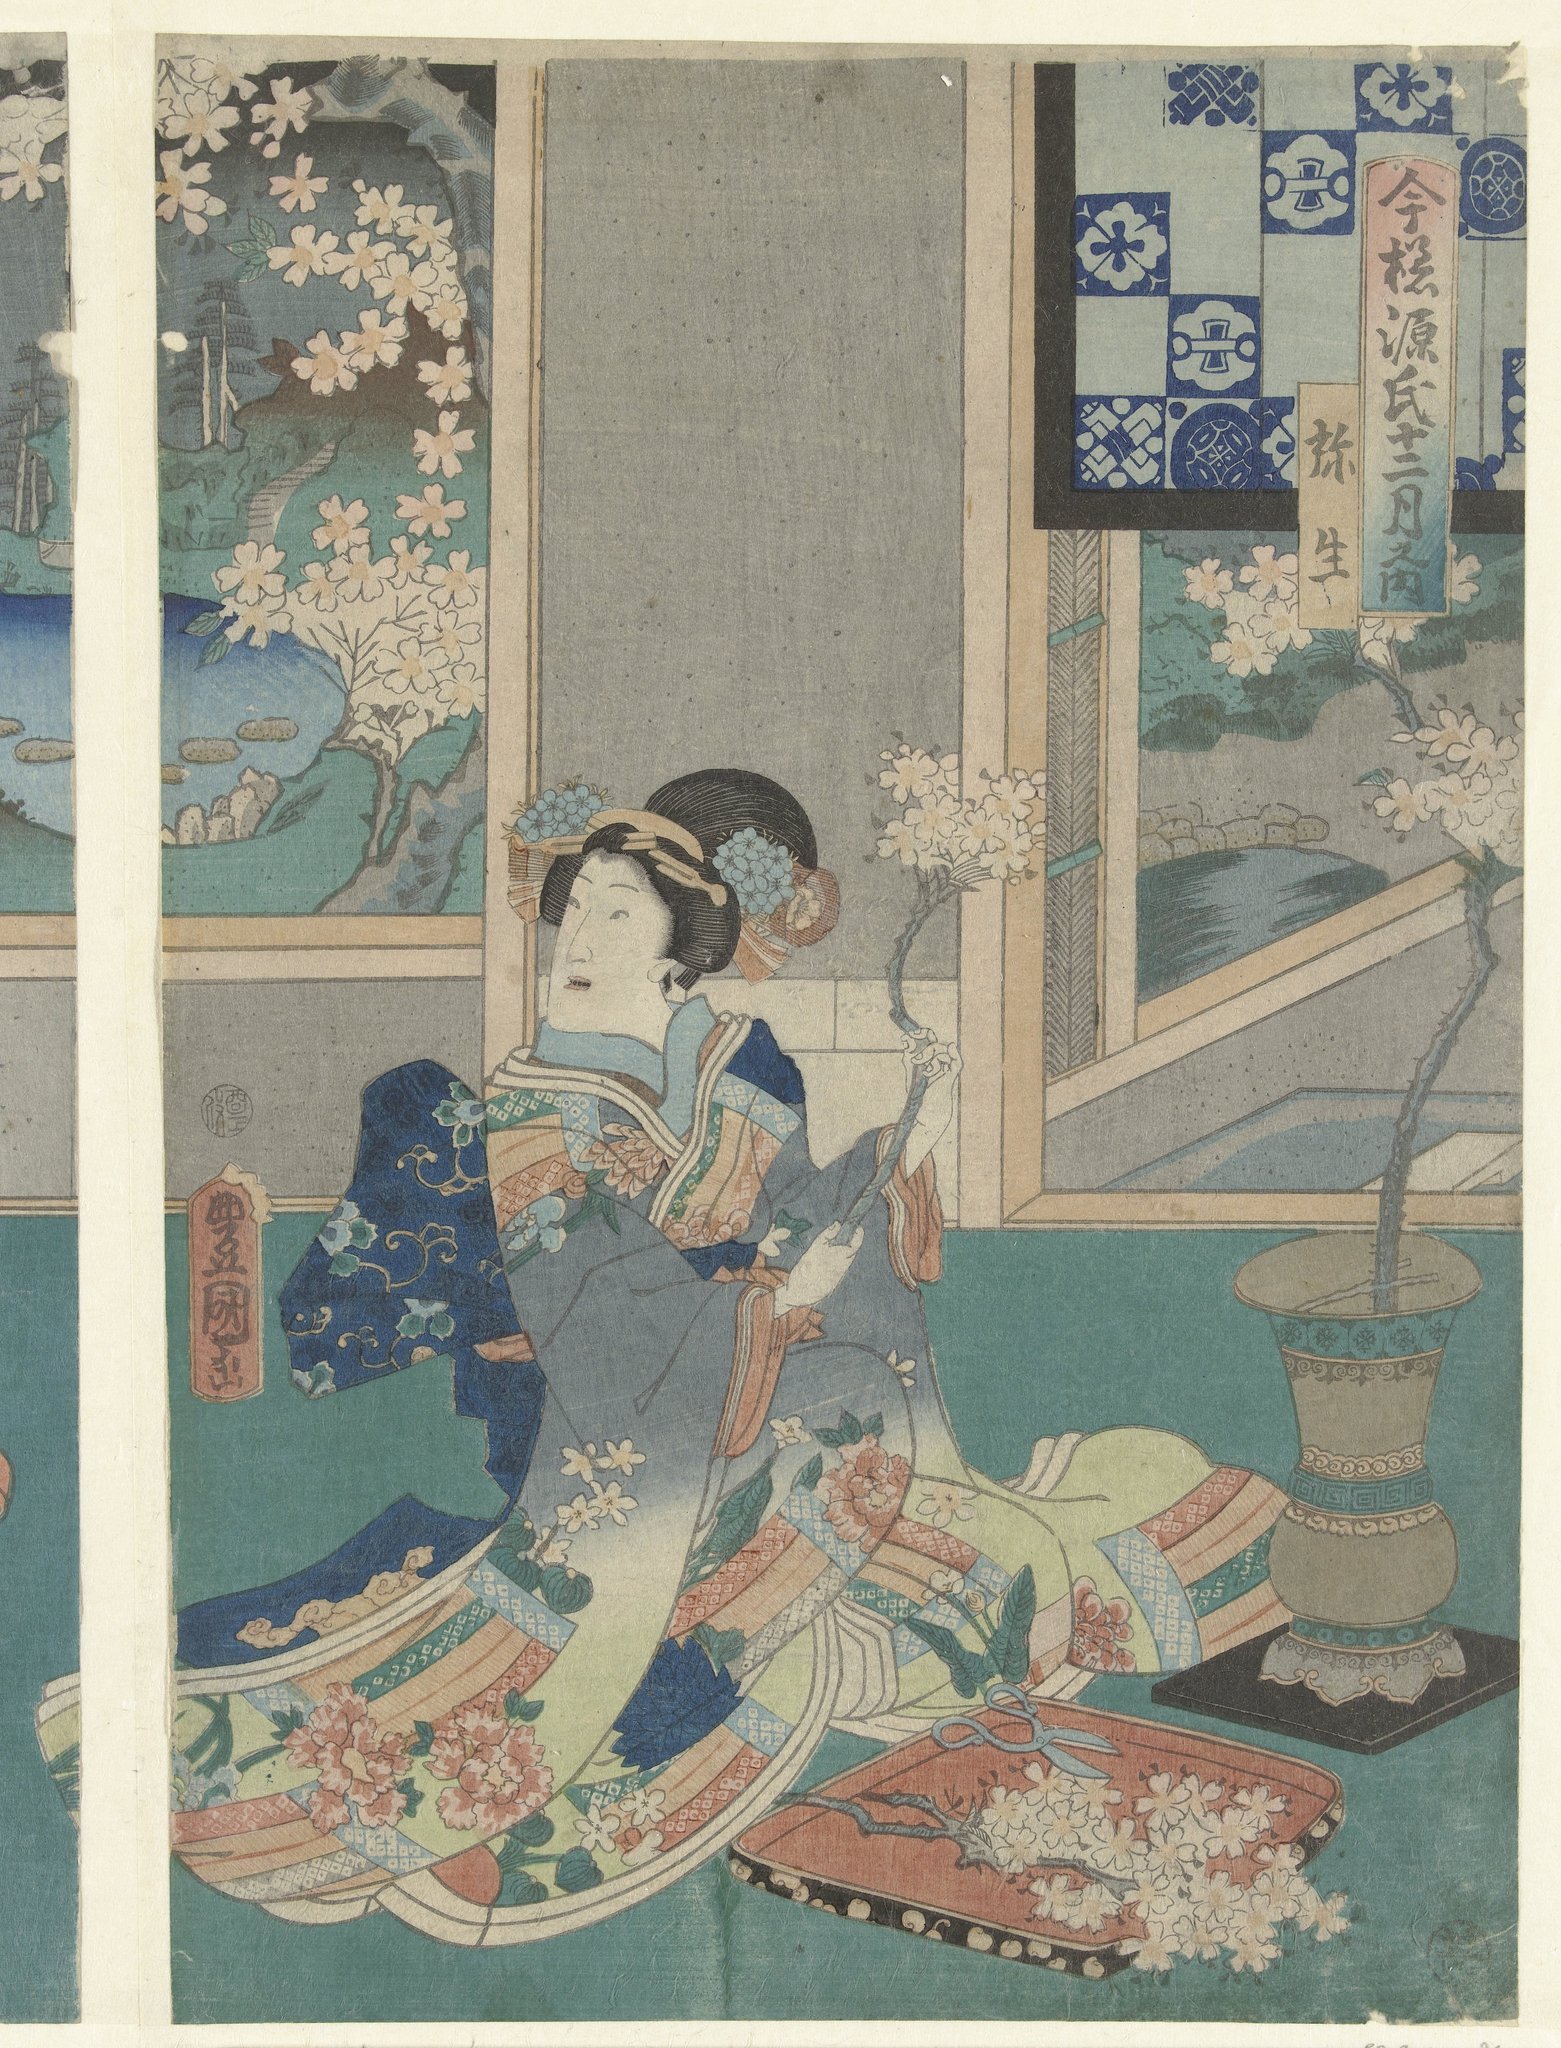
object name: print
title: Moderne Genji verhalen tijdens de twaalf maanden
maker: utagawa kunisada (i)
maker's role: print maker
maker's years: 1786-1865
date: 1861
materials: paper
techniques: woodcut, nishiki e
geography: japan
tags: adult woman, arranging flowers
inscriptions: date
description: Bloemschikkende vrouw, in kamer met uitzicht op een tuin met vijver en bloesemende bomen.